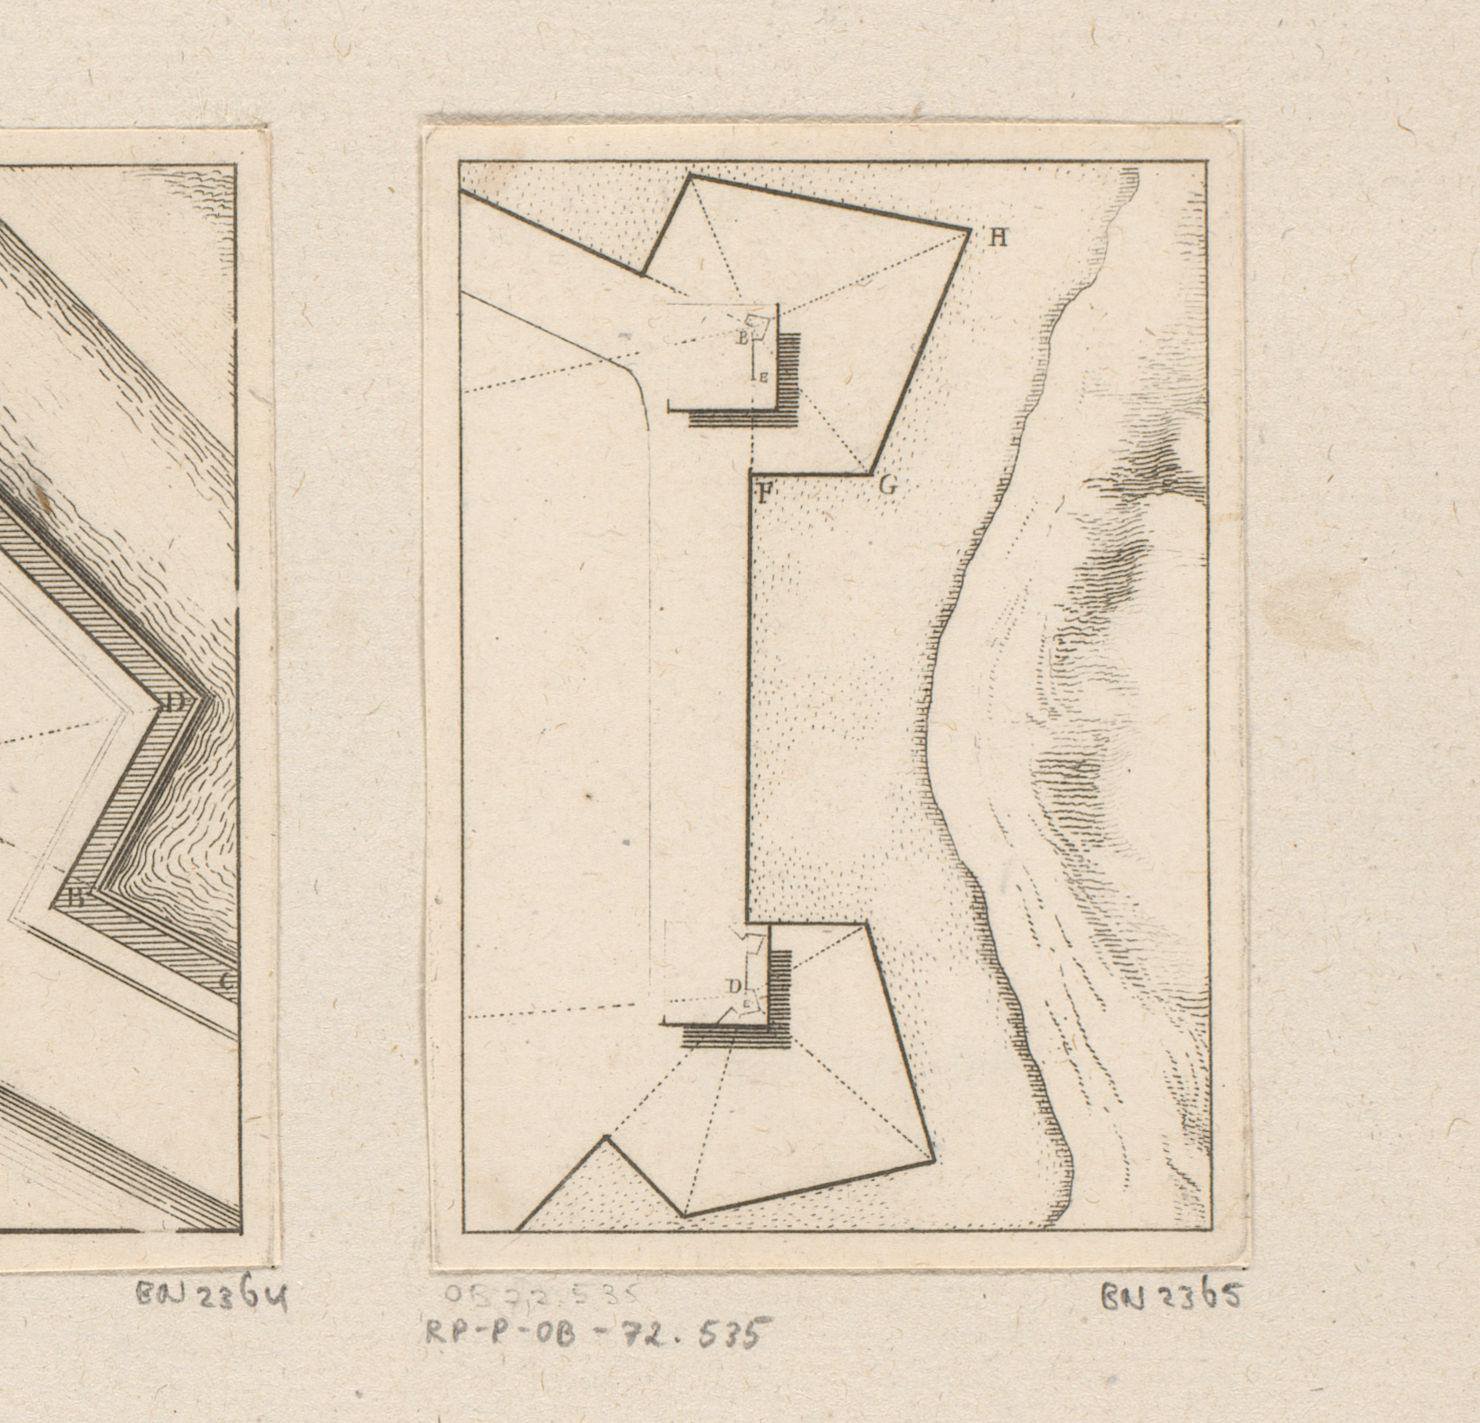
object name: book illustration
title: Plattegrond van twee bastions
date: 1669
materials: paper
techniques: etching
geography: france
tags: fortress, planimetry, geometry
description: Prent toegevoegd aan: Pratique de la géometrie, sur le papier et sur le terrain. Avec un nouvel ordre et une méthode particulière. Parijs: Thomas Jolly, 1669.